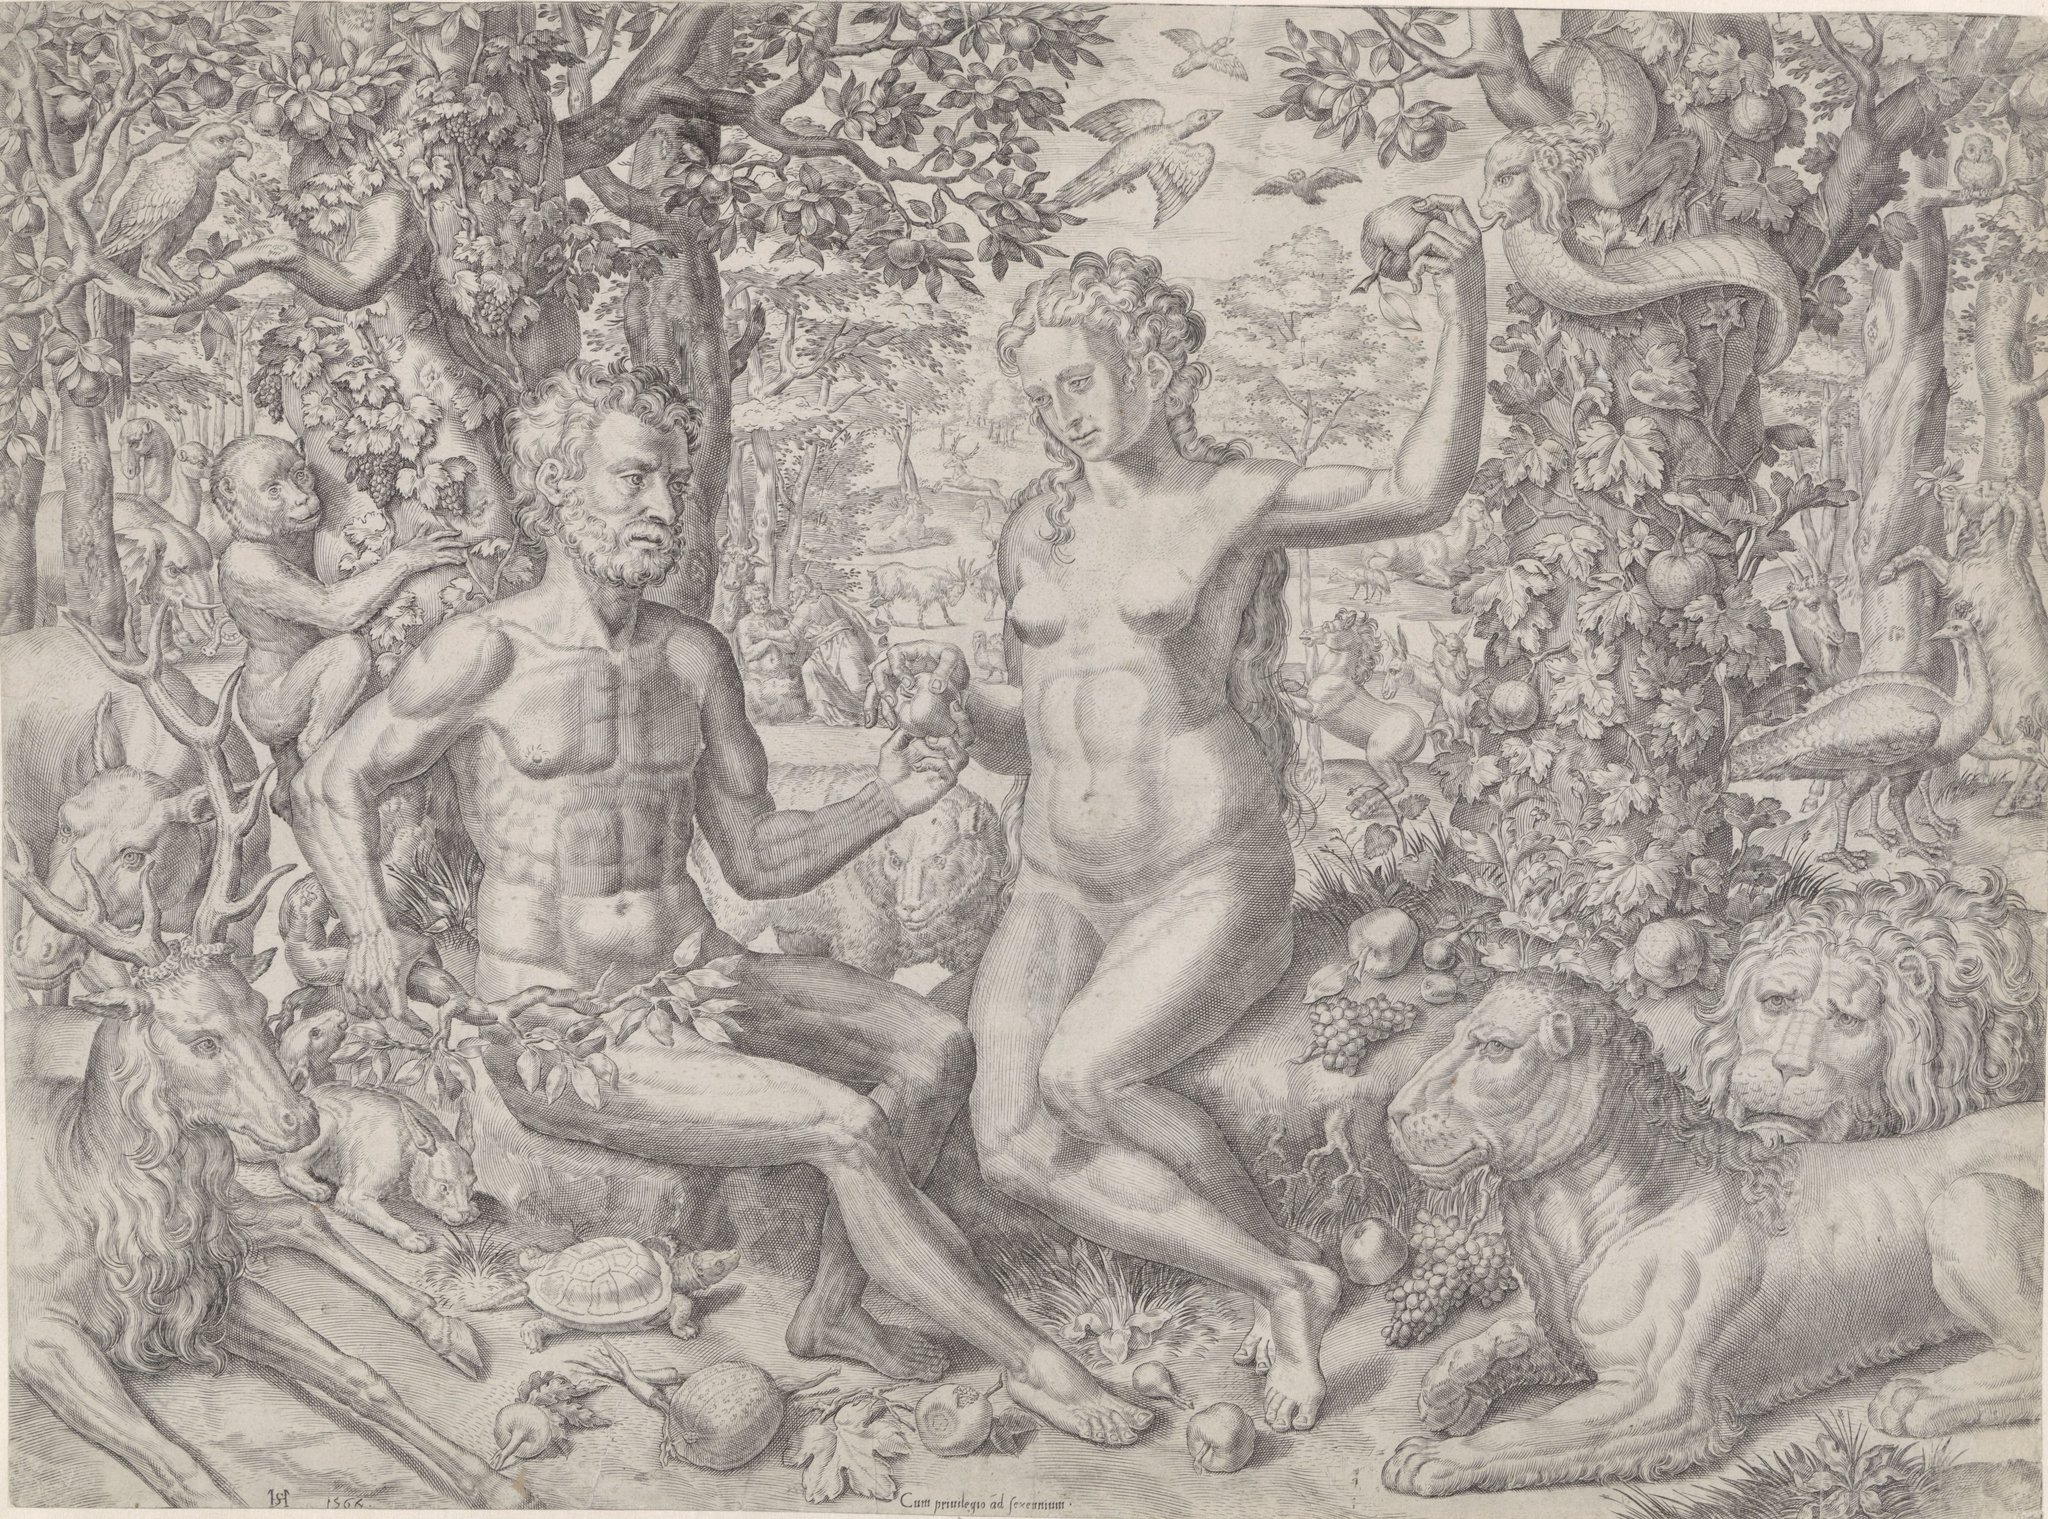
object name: print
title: Zondeval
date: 1566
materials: paper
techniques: engraving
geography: germany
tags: god fashions man from clay, temptation and fall (scenes with both adam and eve)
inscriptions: collector's mark: Lugt 2760, monogram and date: ‘HS 1566’, collector's mark: Lugt 2228, privilege: ‘Cum privilegio ad sexenium’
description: Adam en Eva zitten in het paradijs. Eva reikt Adam de appel aan, terwijl de slang zich kronkelt om de boom van de kennis van goed en kwaad. Ze zijn omringd door dieren. Rechts twee leeuwen en een pauw, links een hert, rund en aap. Op de achtergrond schept God de Vader Adam.